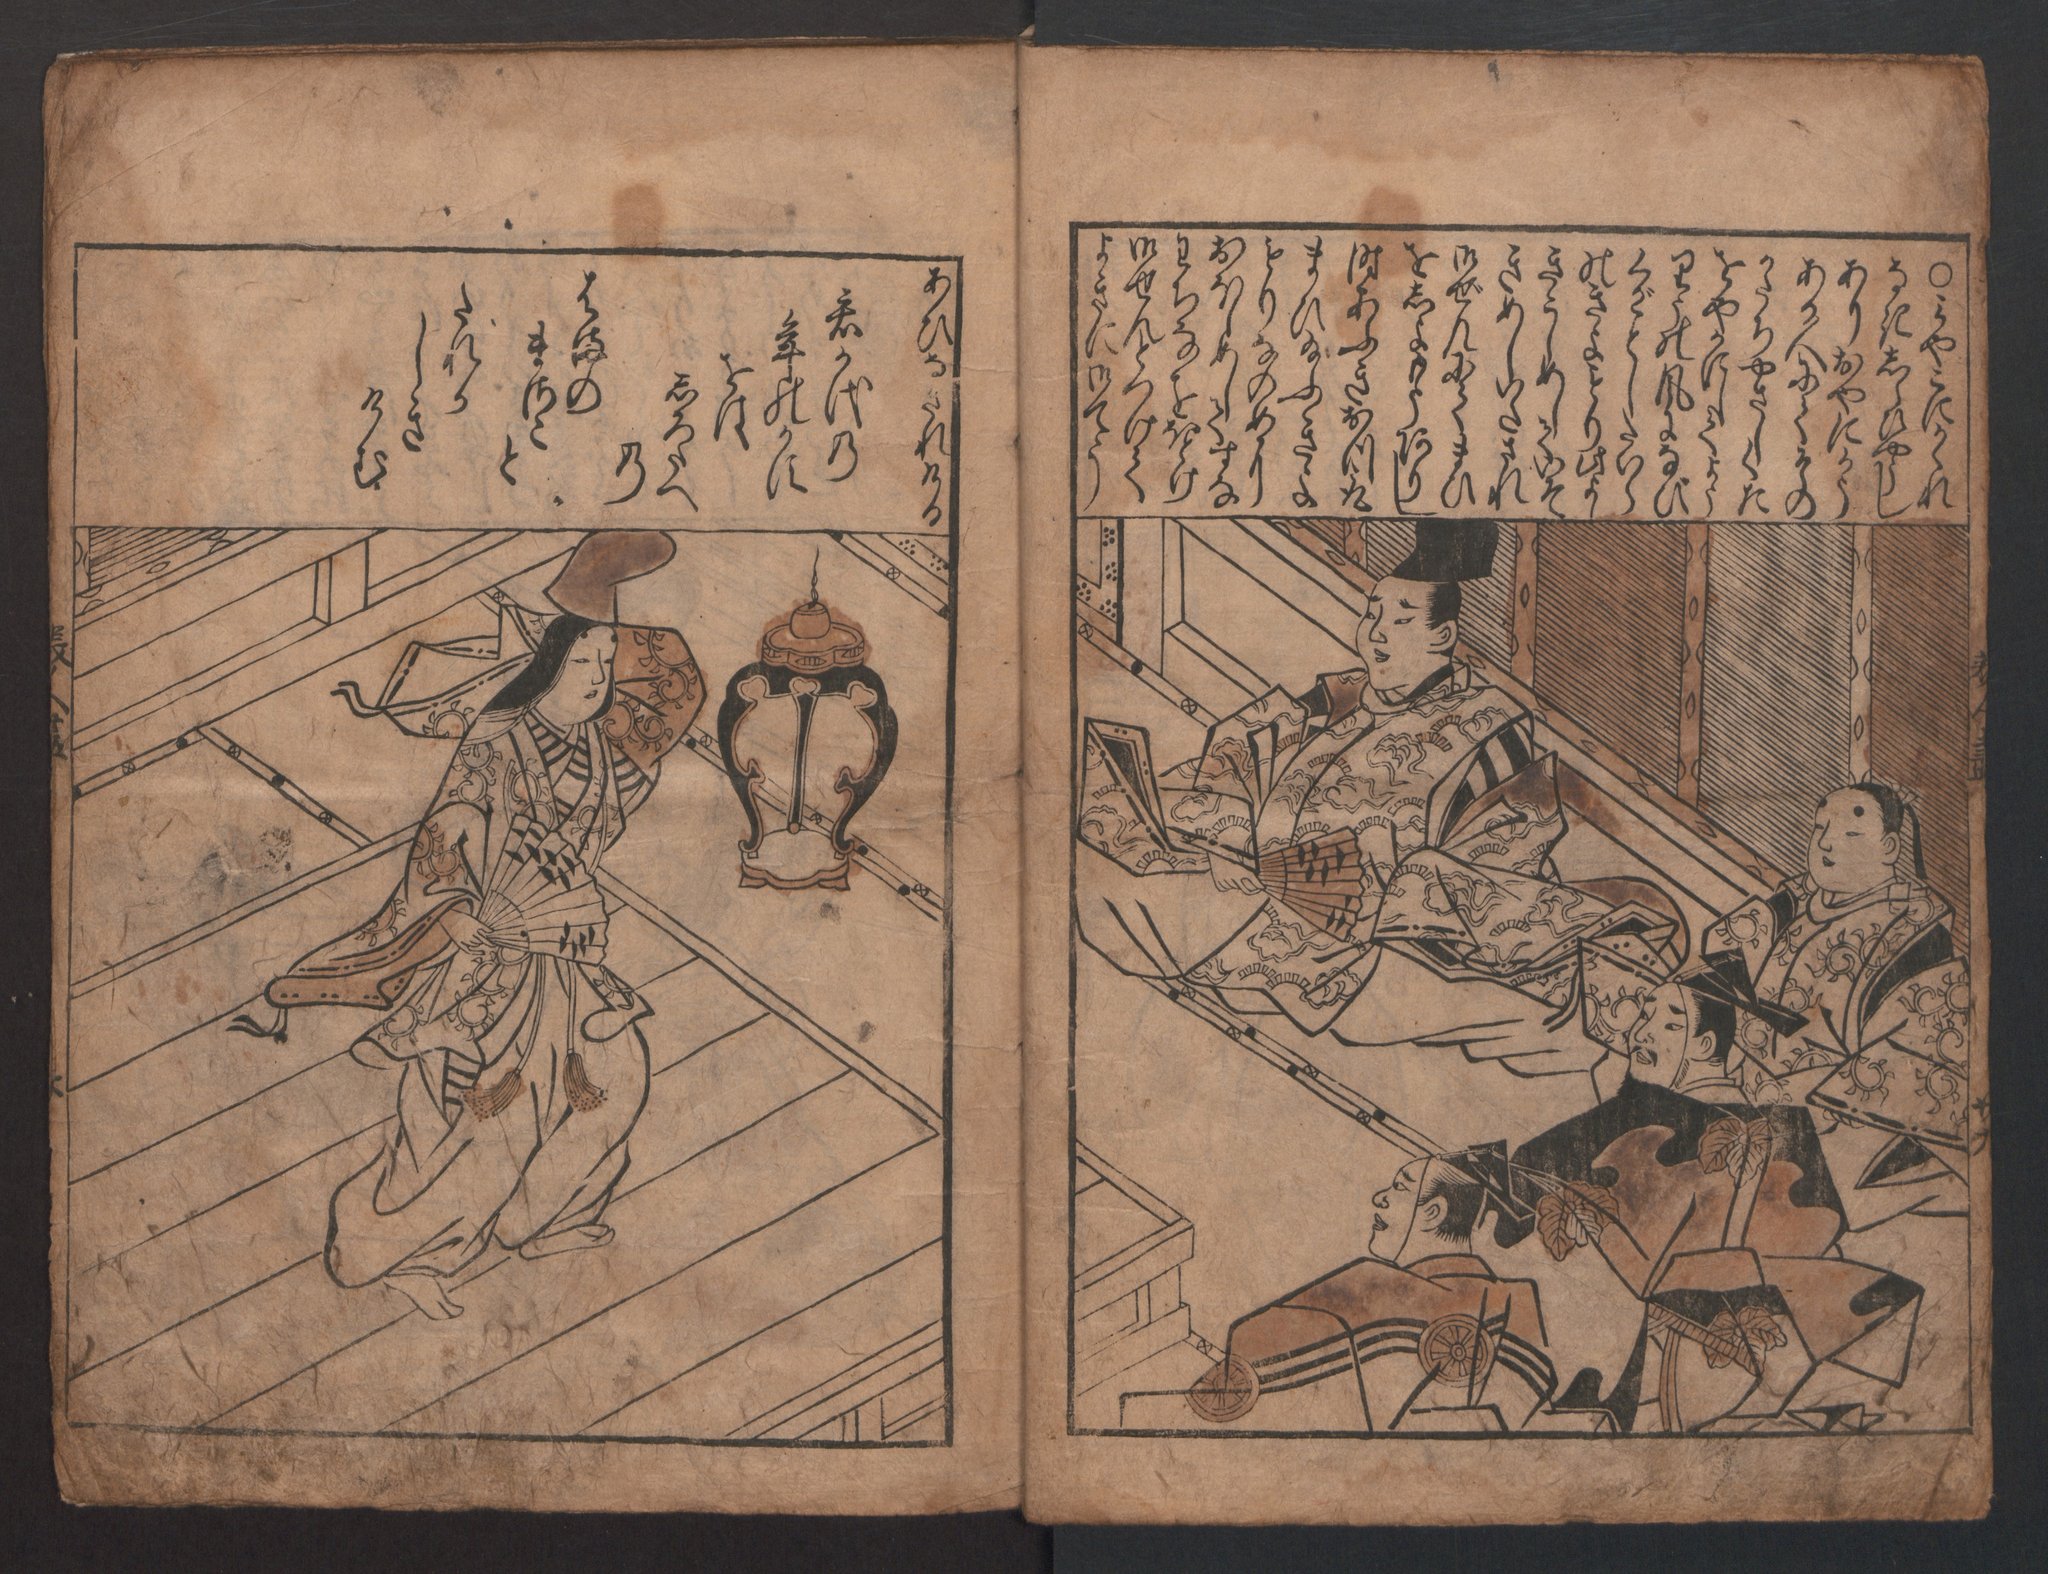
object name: illustrated book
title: Illustrations of Beautiful Women (Bijin e-zukushi) 美人絵づくし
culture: japanese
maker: hishikawa moronobu 菱川師宣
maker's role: artist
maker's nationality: japanese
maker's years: 1618-1694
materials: ink, paper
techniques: woodblock print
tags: men,women